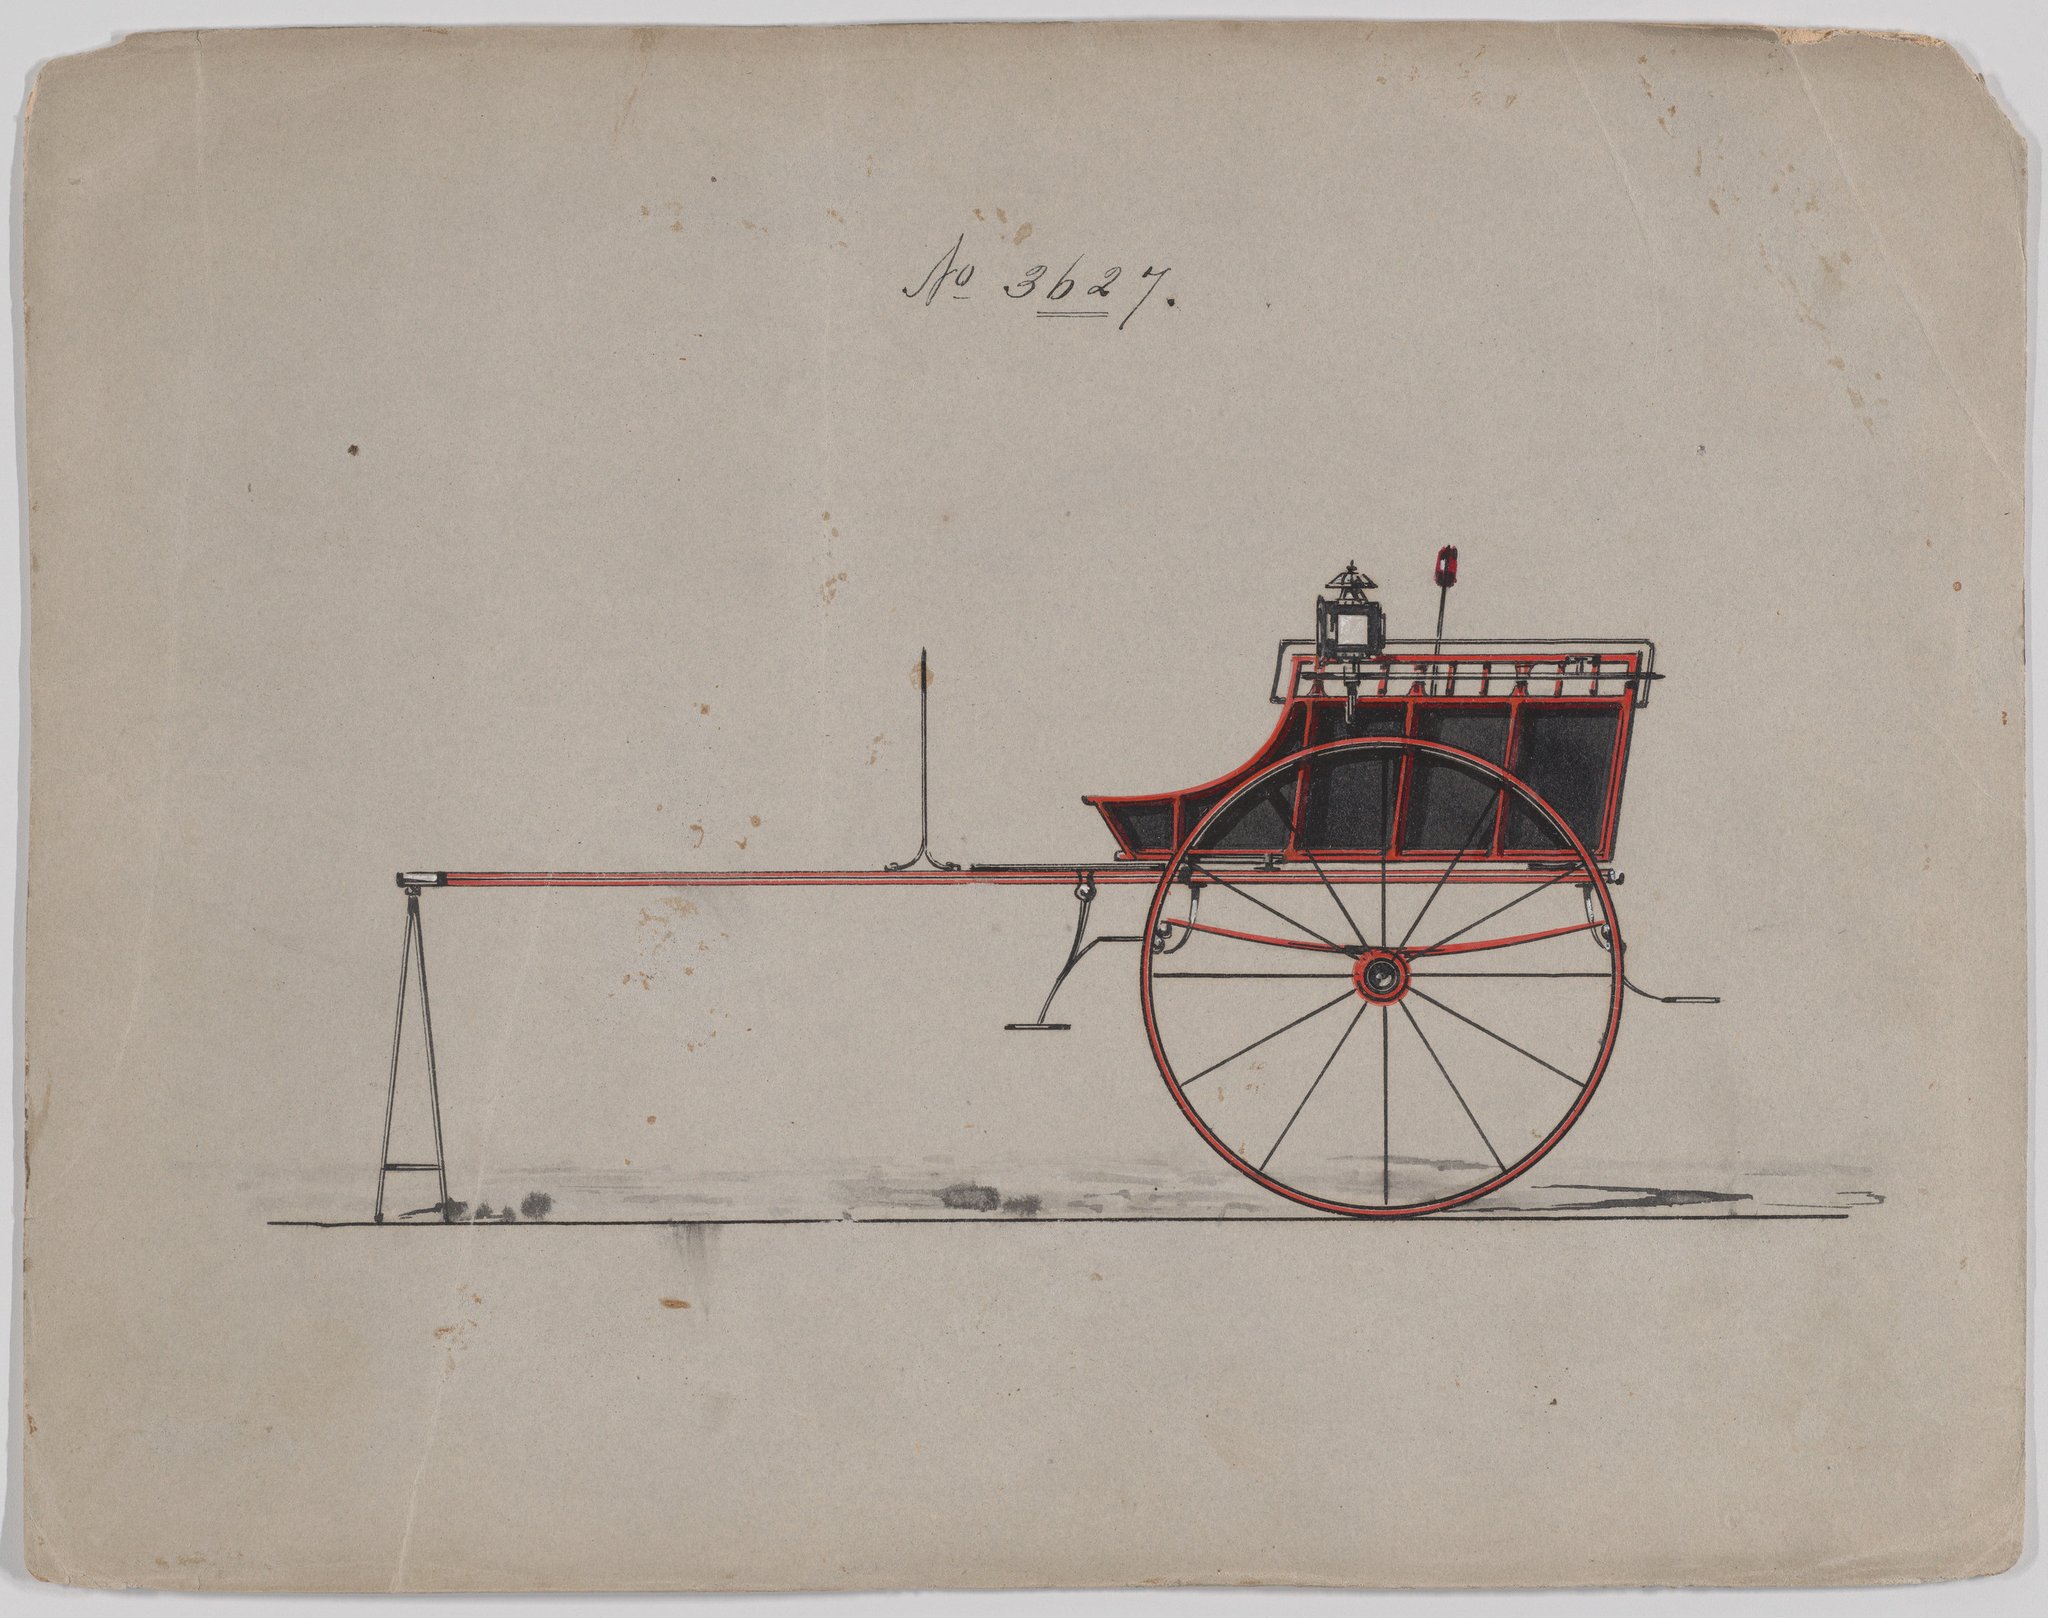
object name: drawing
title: Whitechapel Cart #3627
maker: brewster & co.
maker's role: manufacturer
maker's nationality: american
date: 1880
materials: gouache, gum arabic, ink, watercolor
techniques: pen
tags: carriages